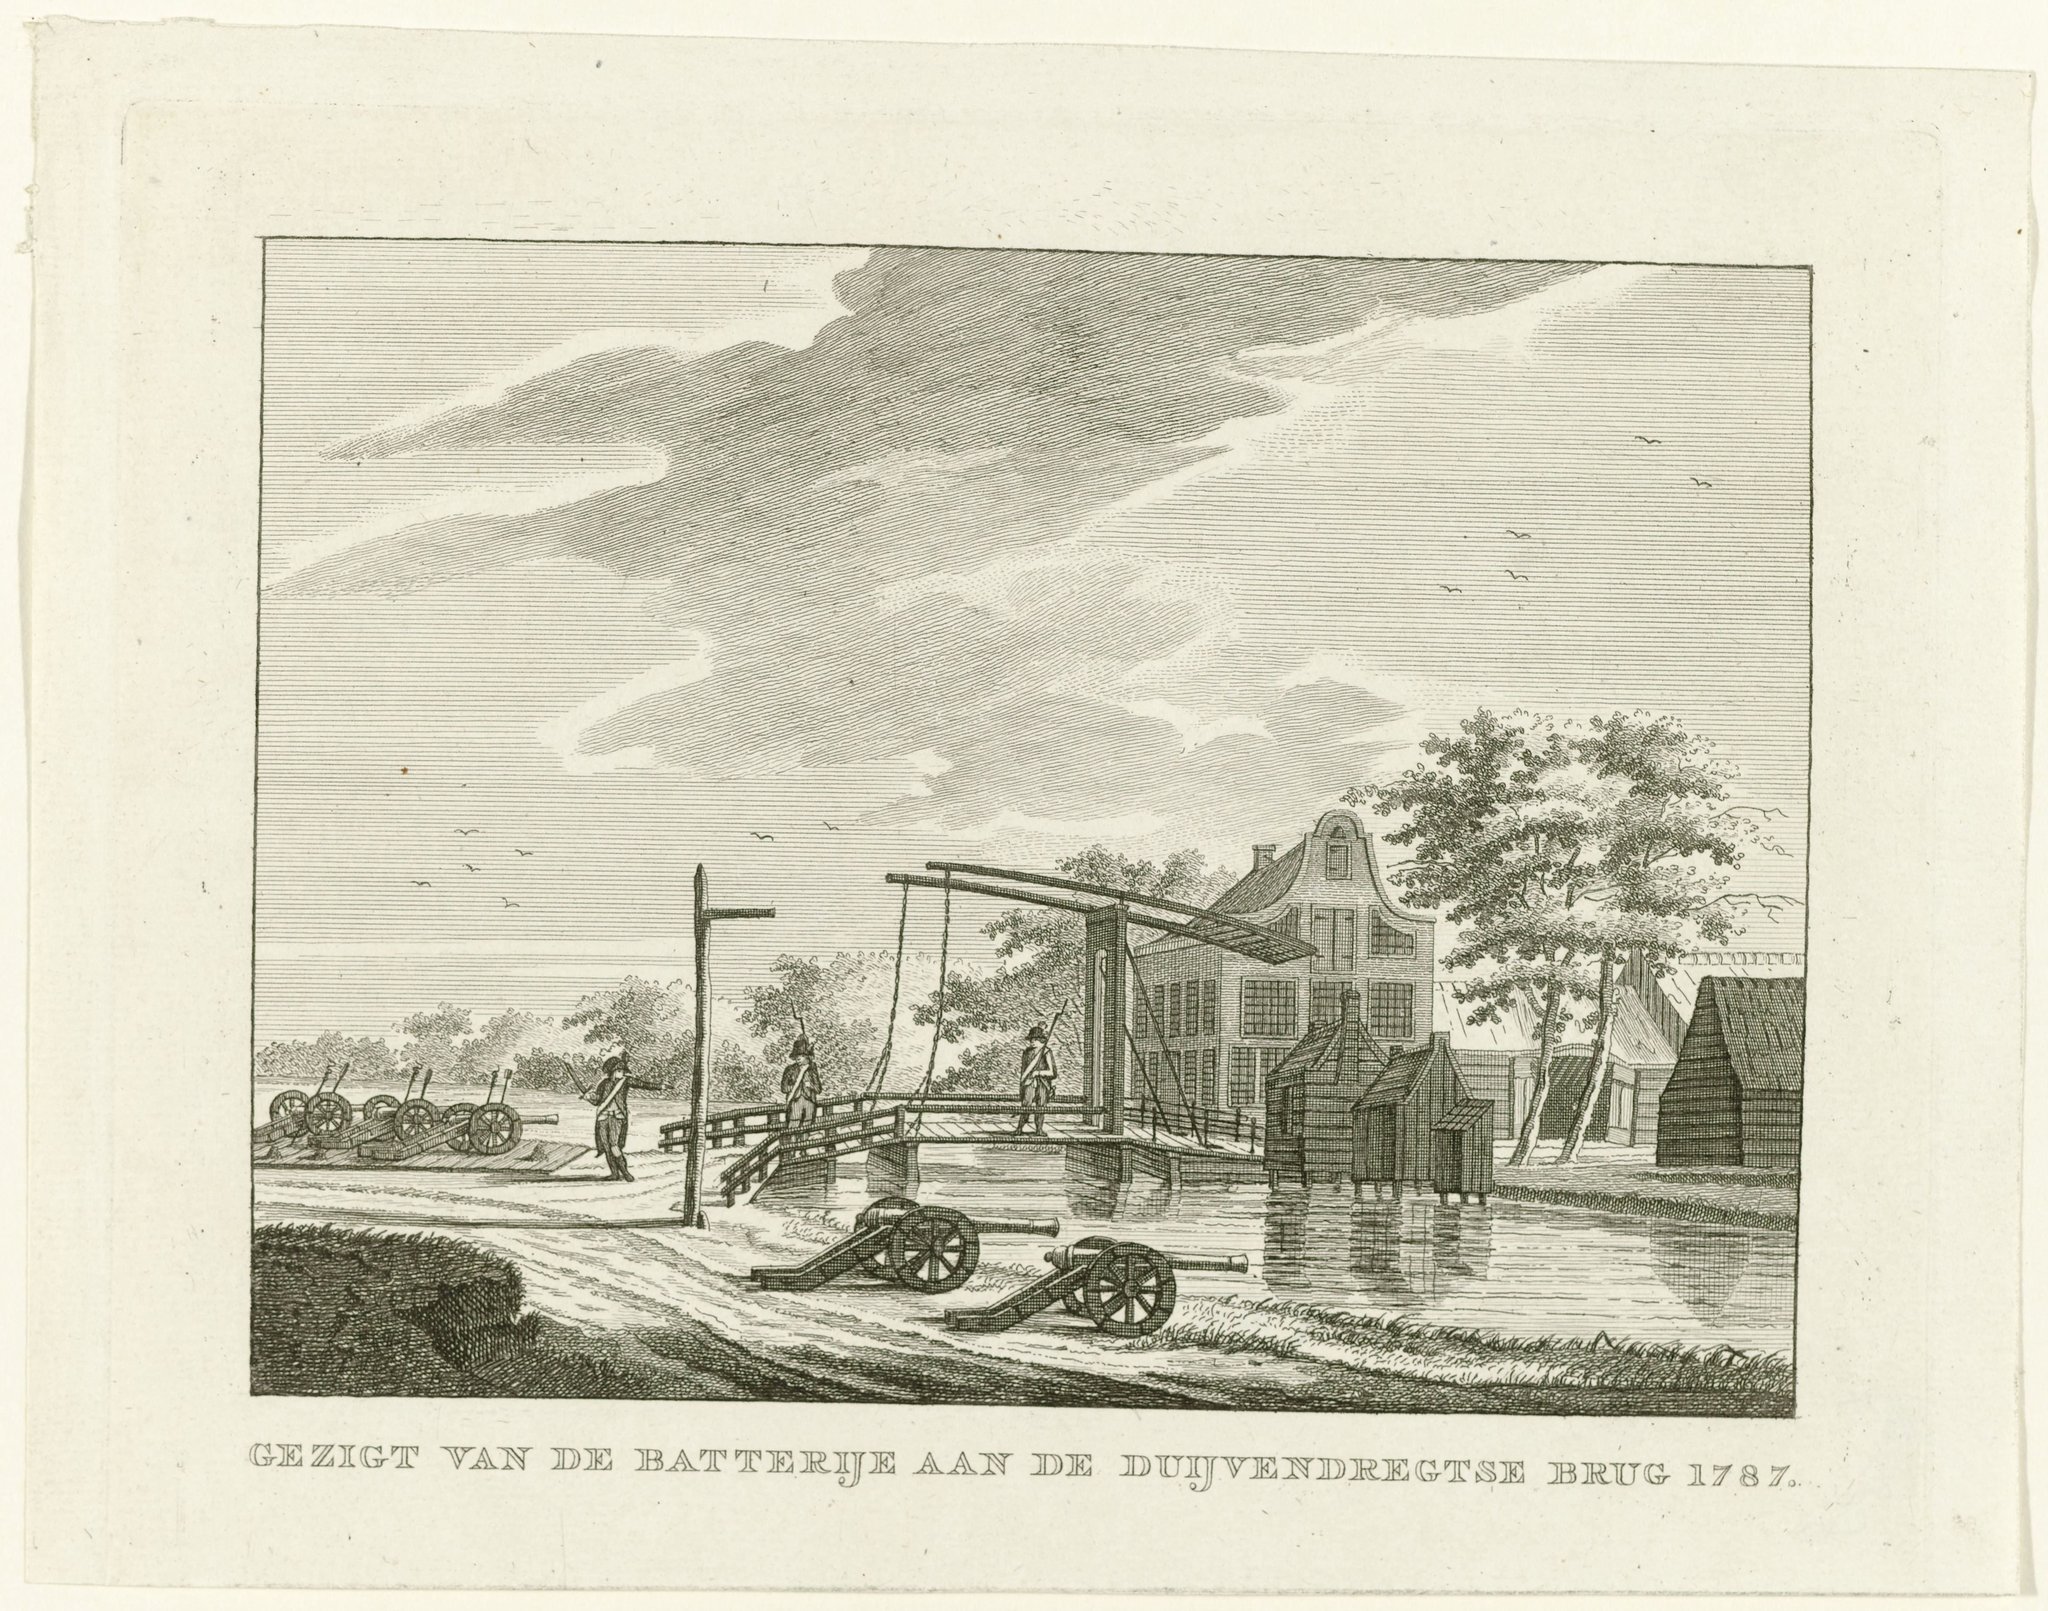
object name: print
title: Gezigt van de batterije aan de Duijvendregtse Brug 1787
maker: Anonymous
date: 1787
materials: paper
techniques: etching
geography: northern netherlands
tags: defence of fortification or city, defensive measures (military)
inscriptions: collector's mark: Lugt 2228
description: Battterij aan de Duivendrechtsebrug. Onderdeel van een serie van veertien platen van de verdedigingen aangelegd door de patriotten rondom Amsterdam ten tijde van de inval van de Pruisische troepen in september 1787.